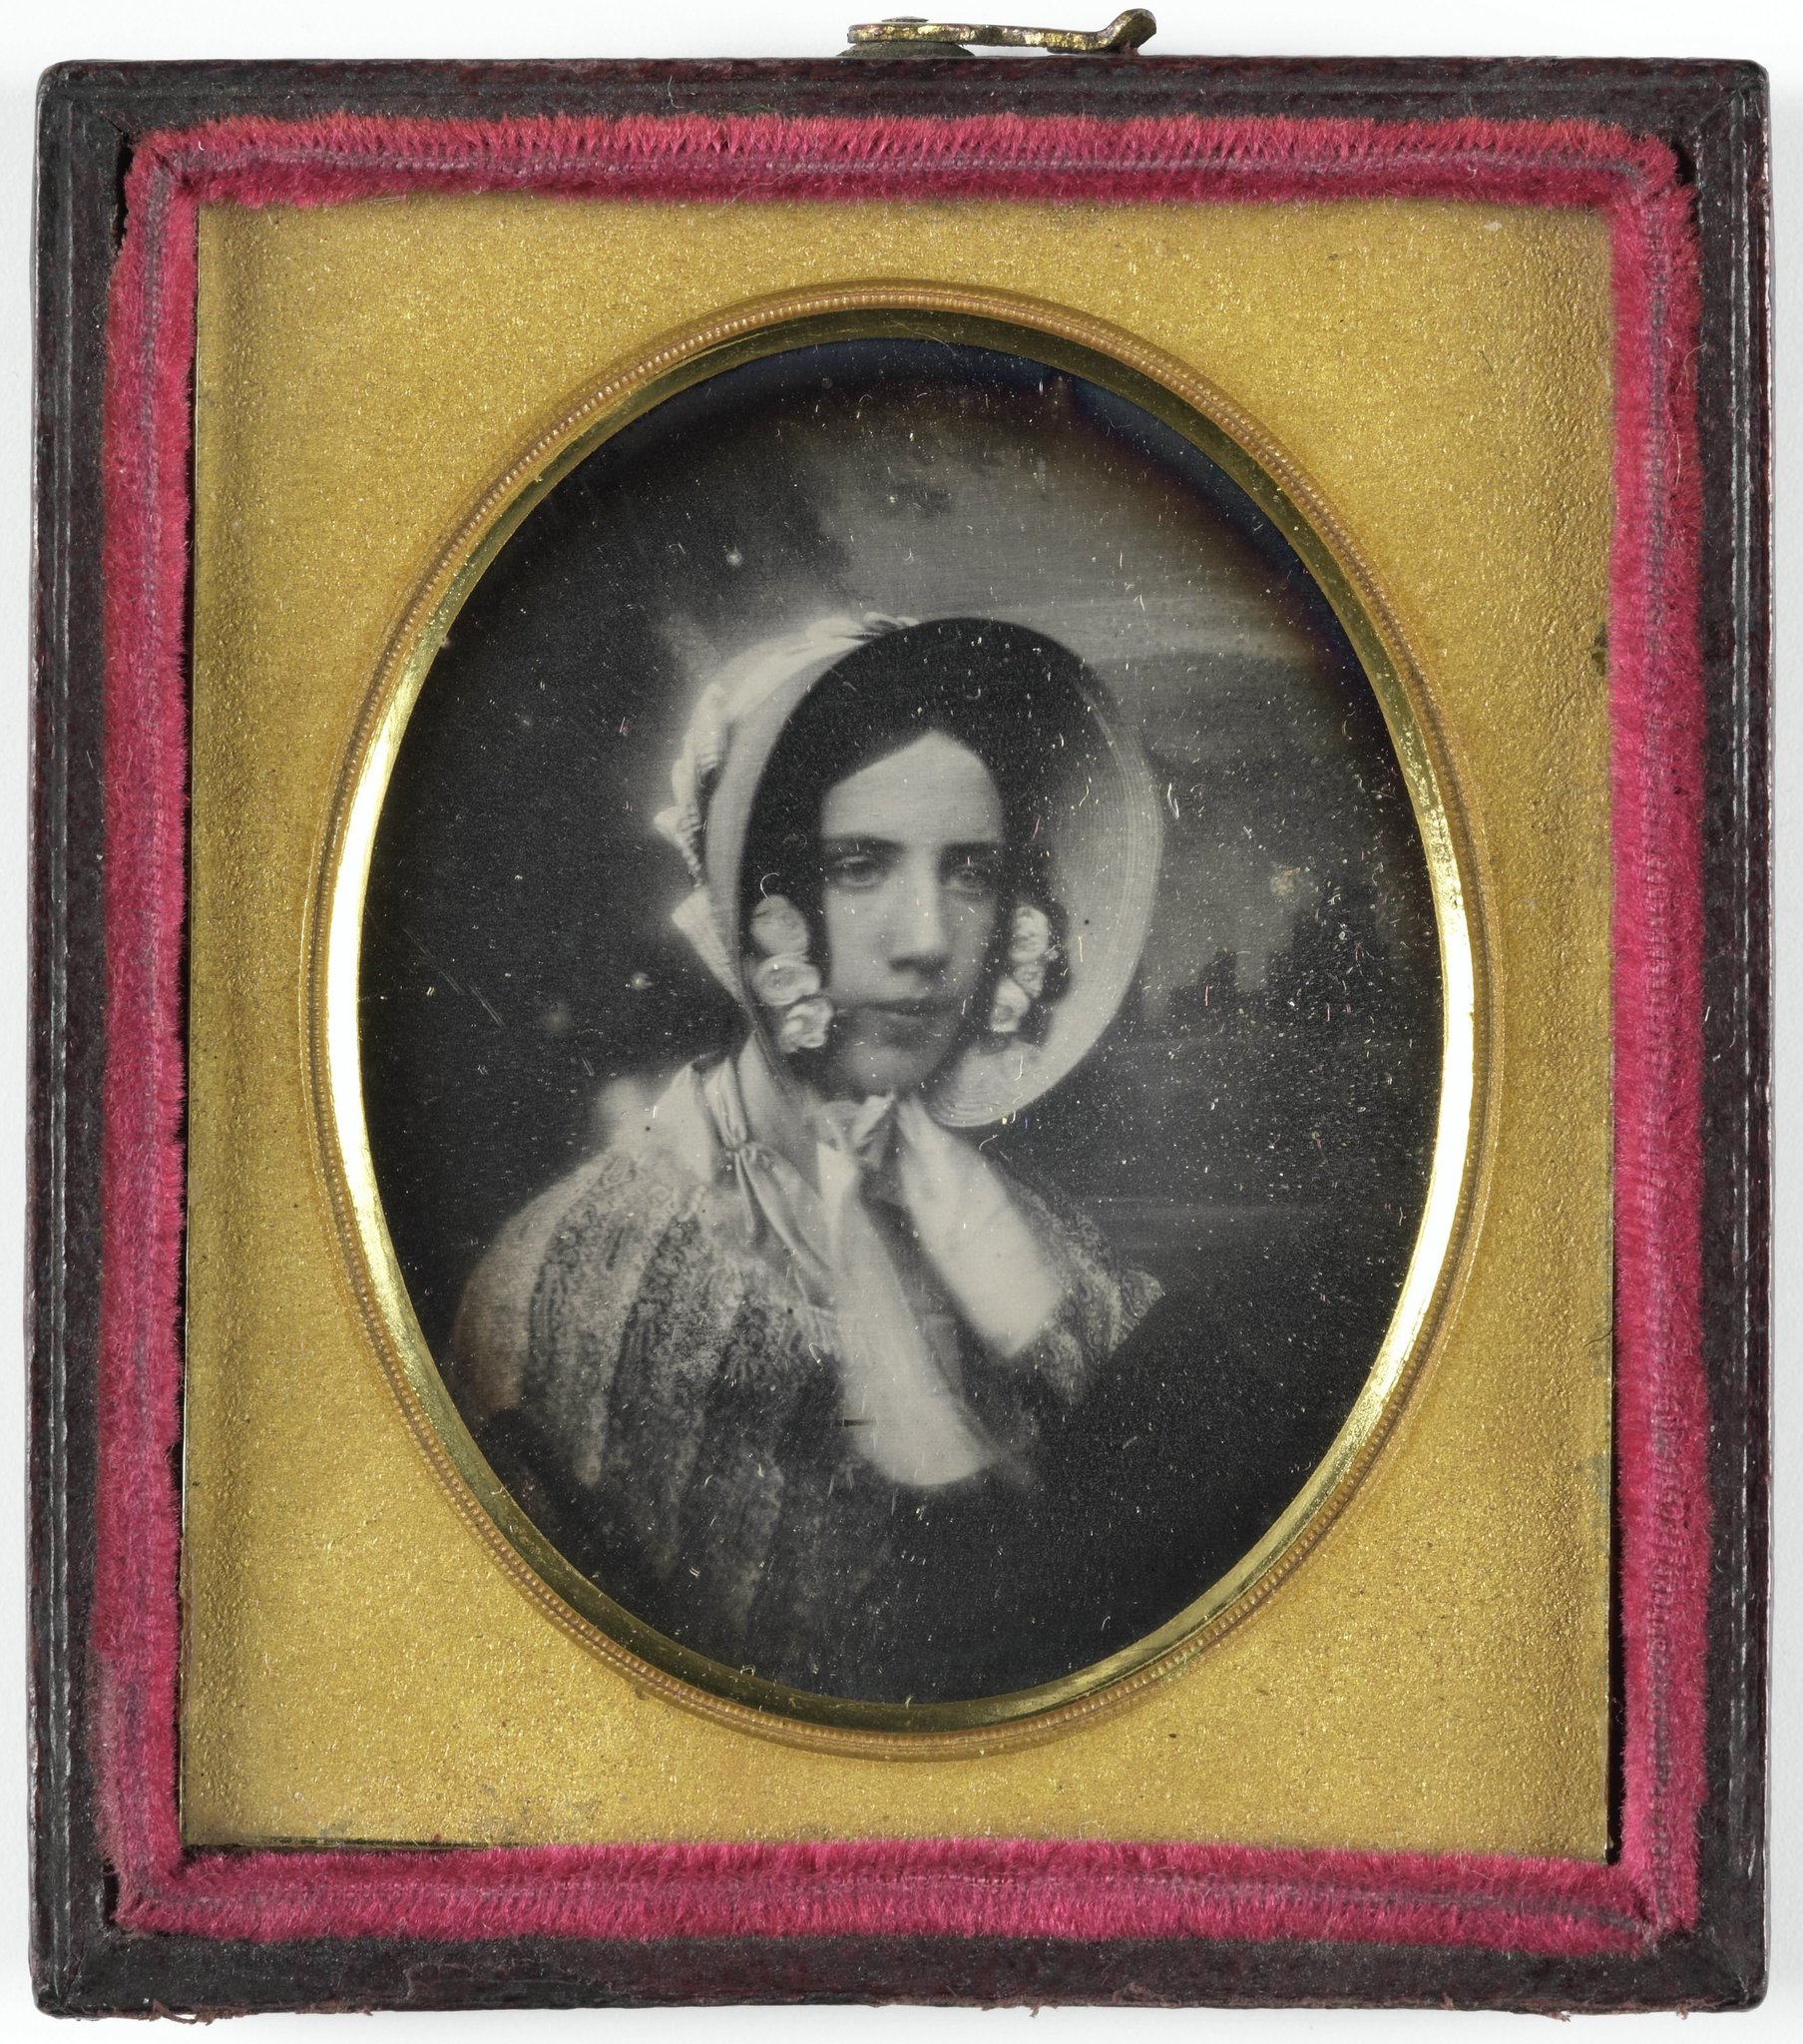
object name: photograph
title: Portret van een onbekende jonge vrouw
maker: Anonymous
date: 1840-1860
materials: copper, glass, leather, velvet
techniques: daguerreotype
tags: adolescent, young woman, maiden, historical persons